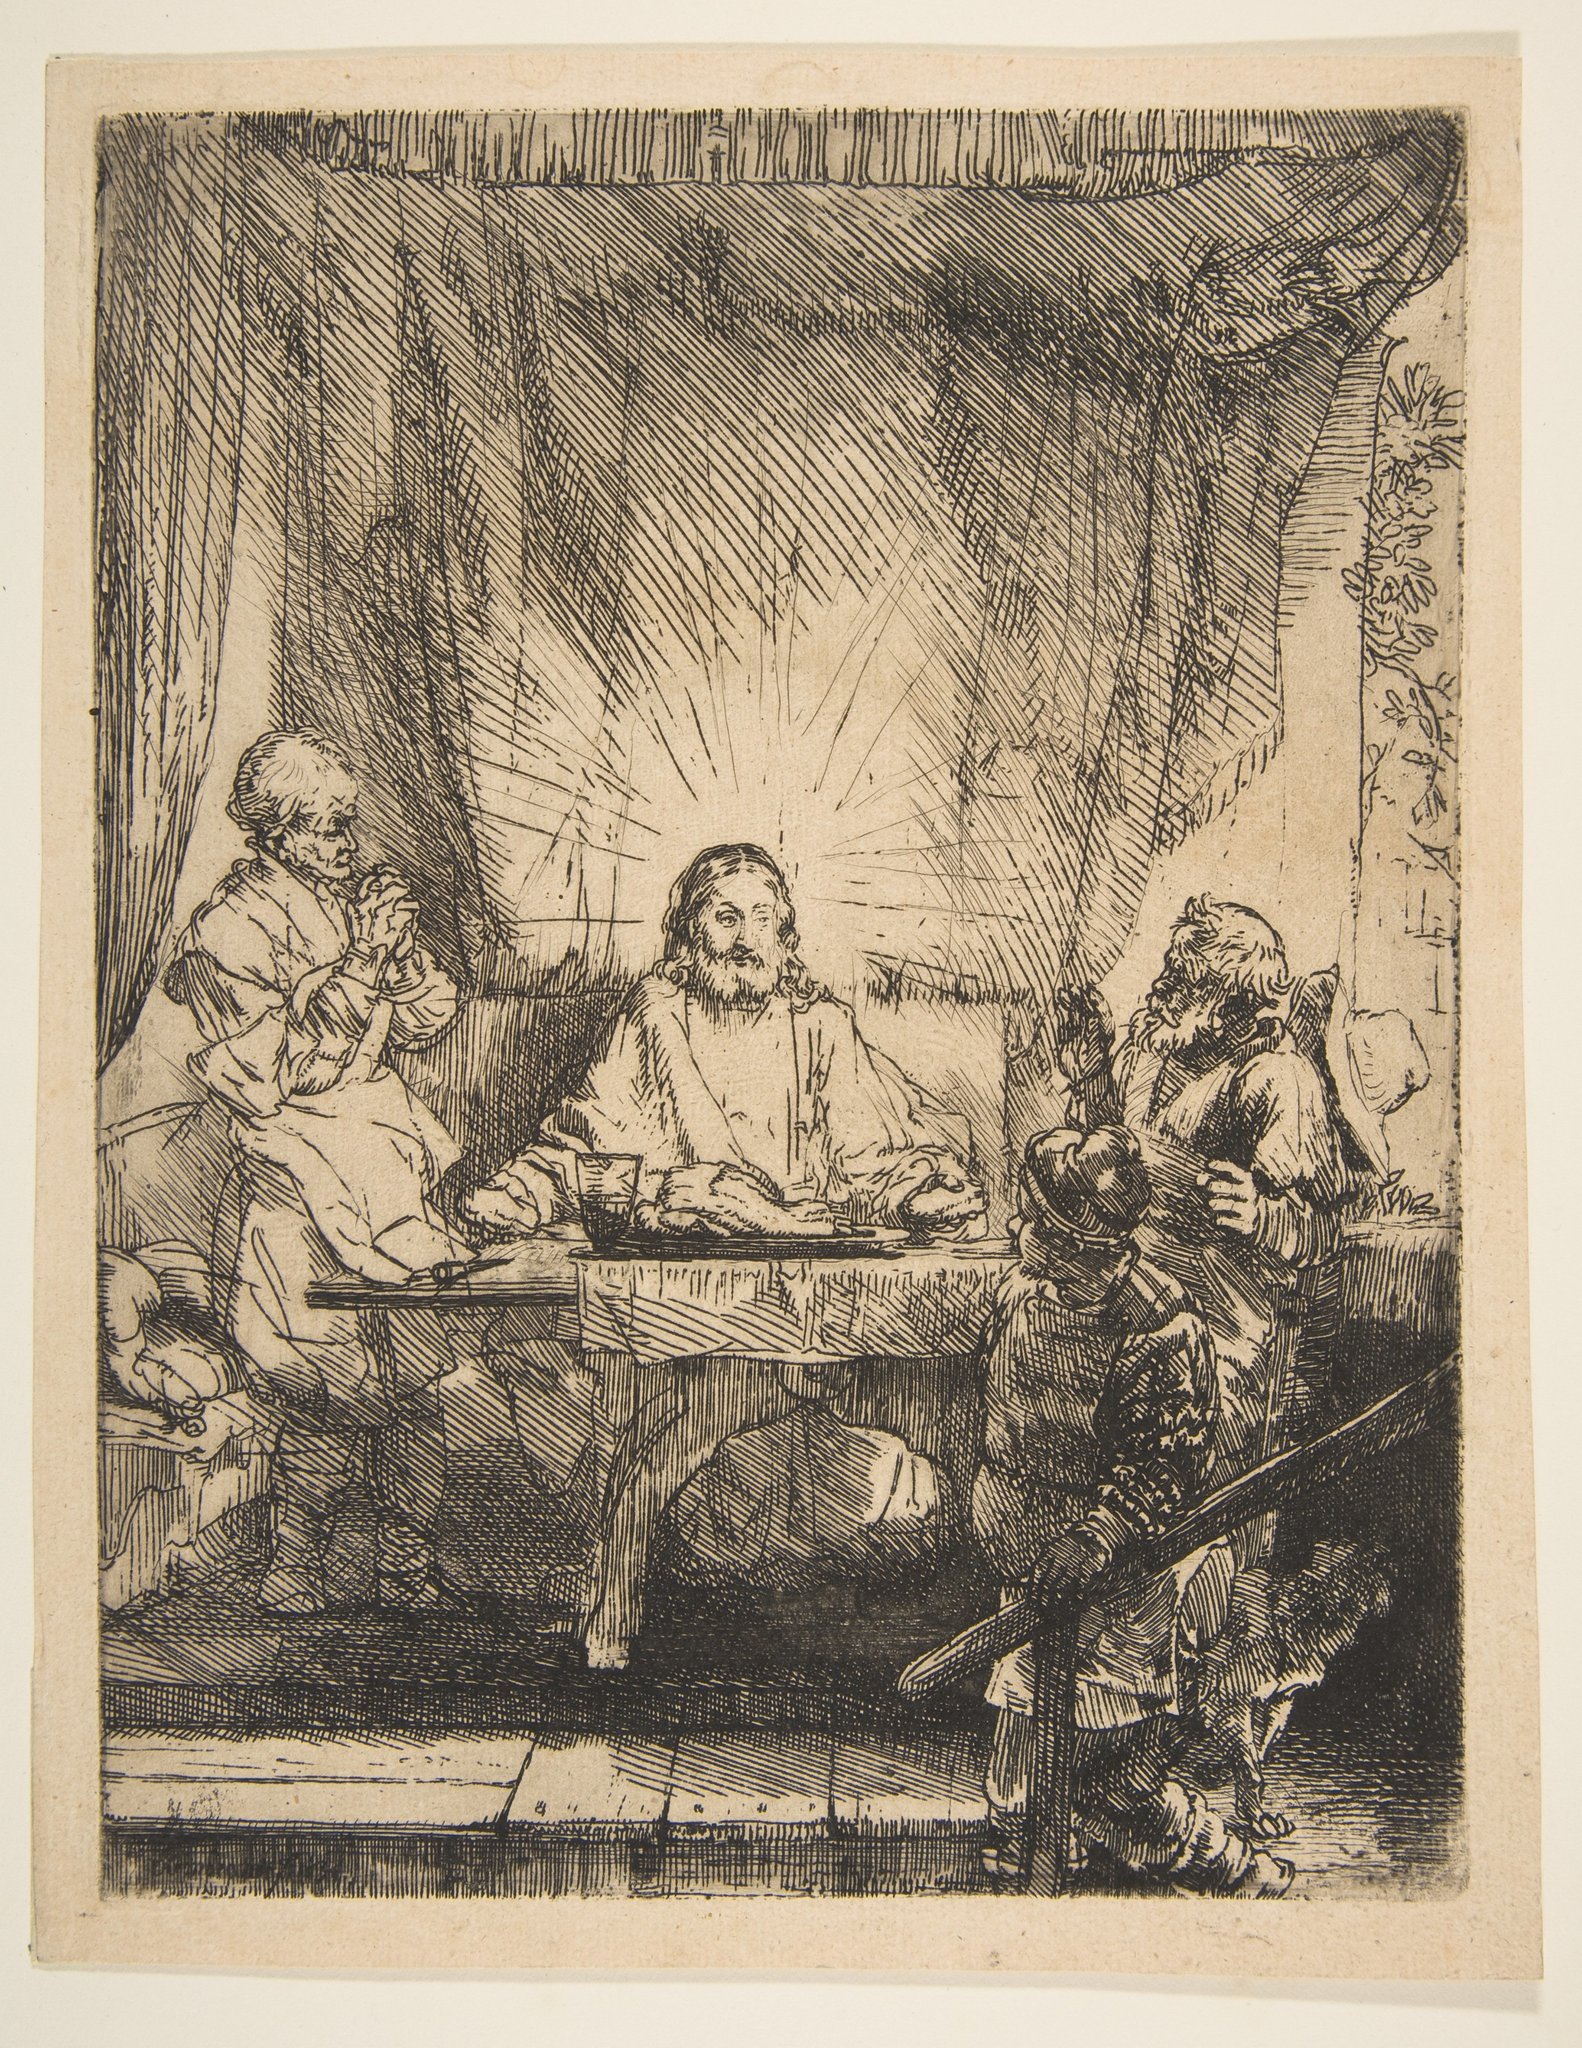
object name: print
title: Christ at Emmaus: The Larger Plate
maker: rembrandt van rijn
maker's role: artist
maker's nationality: dutch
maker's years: 1606-1669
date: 1654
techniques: engraving, drypoint, etching, mezzotint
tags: men,christ